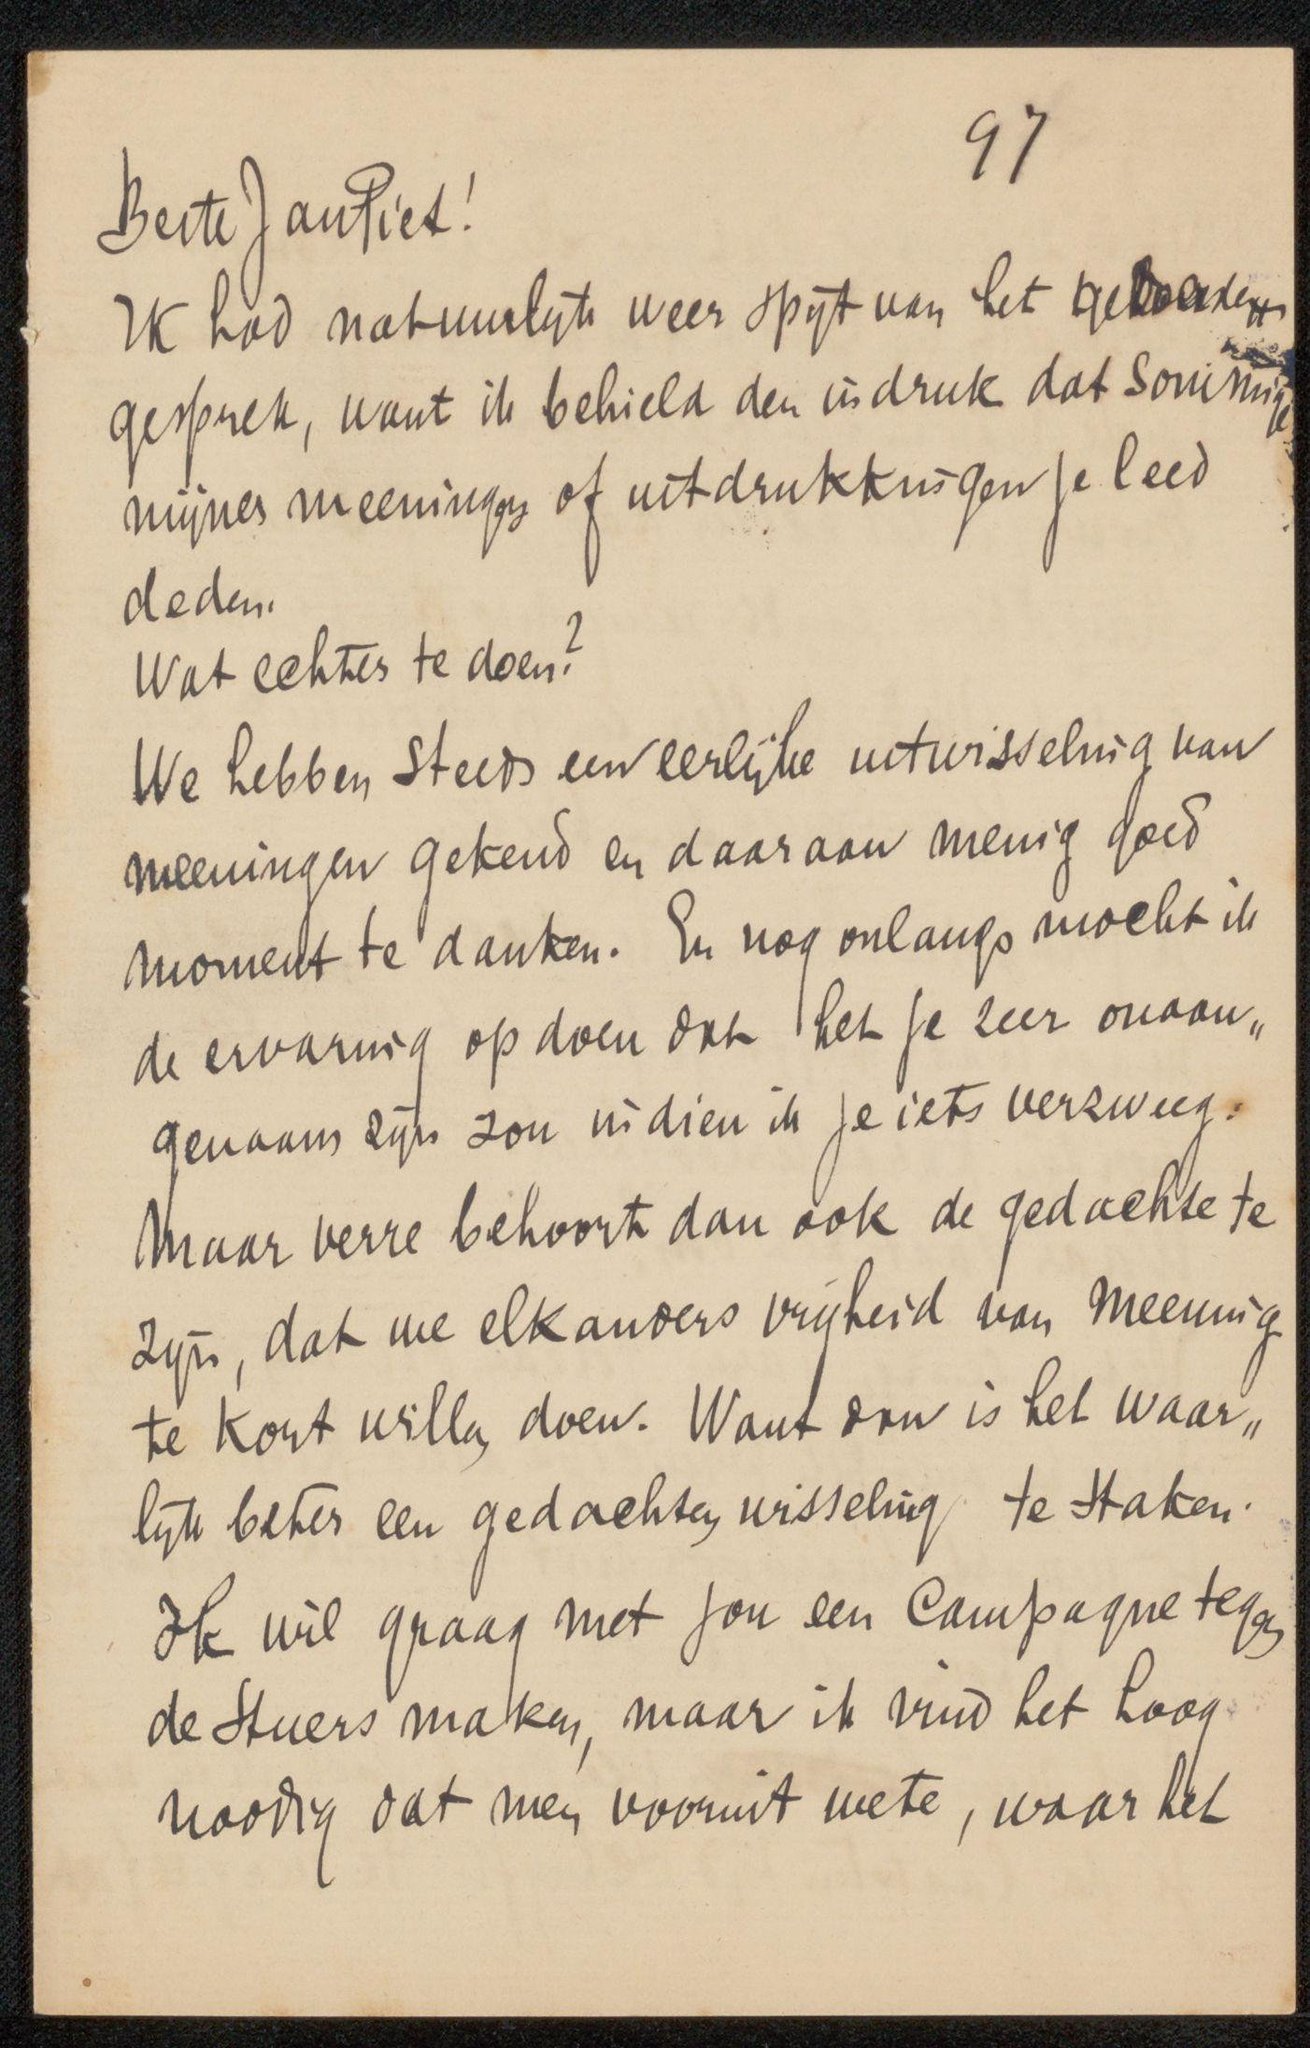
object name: letter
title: Brief aan Jan Veth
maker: antoon derkinderen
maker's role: draughtsman, painter, print maker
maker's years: 1859-1925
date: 1874-1925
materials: ink, paper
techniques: pen, writing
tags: the hague, jozef israëls, dordrecht, amsterdam, painter, print maker, draughtsman, designer, jan veth, maastricht, jonkheer victor eugène louis de stuers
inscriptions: collector's mark: ‘RPK’